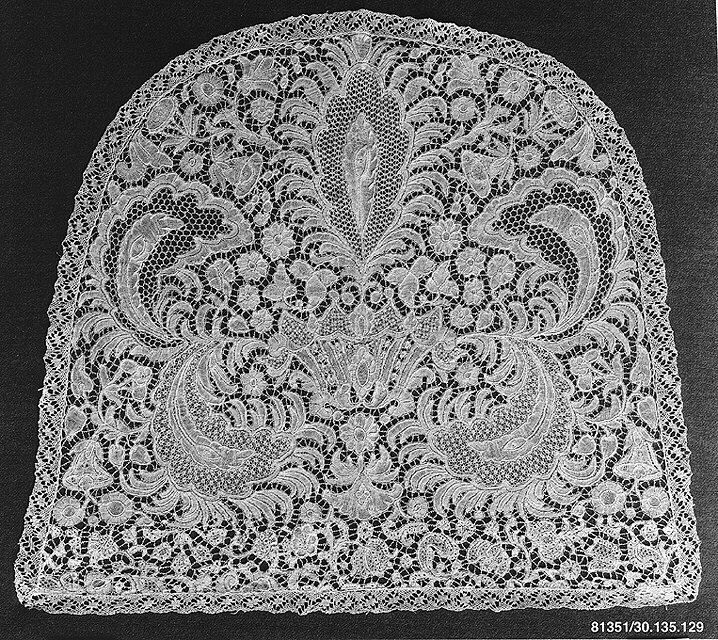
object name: cap crown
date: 1701-1800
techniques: lace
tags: flowers